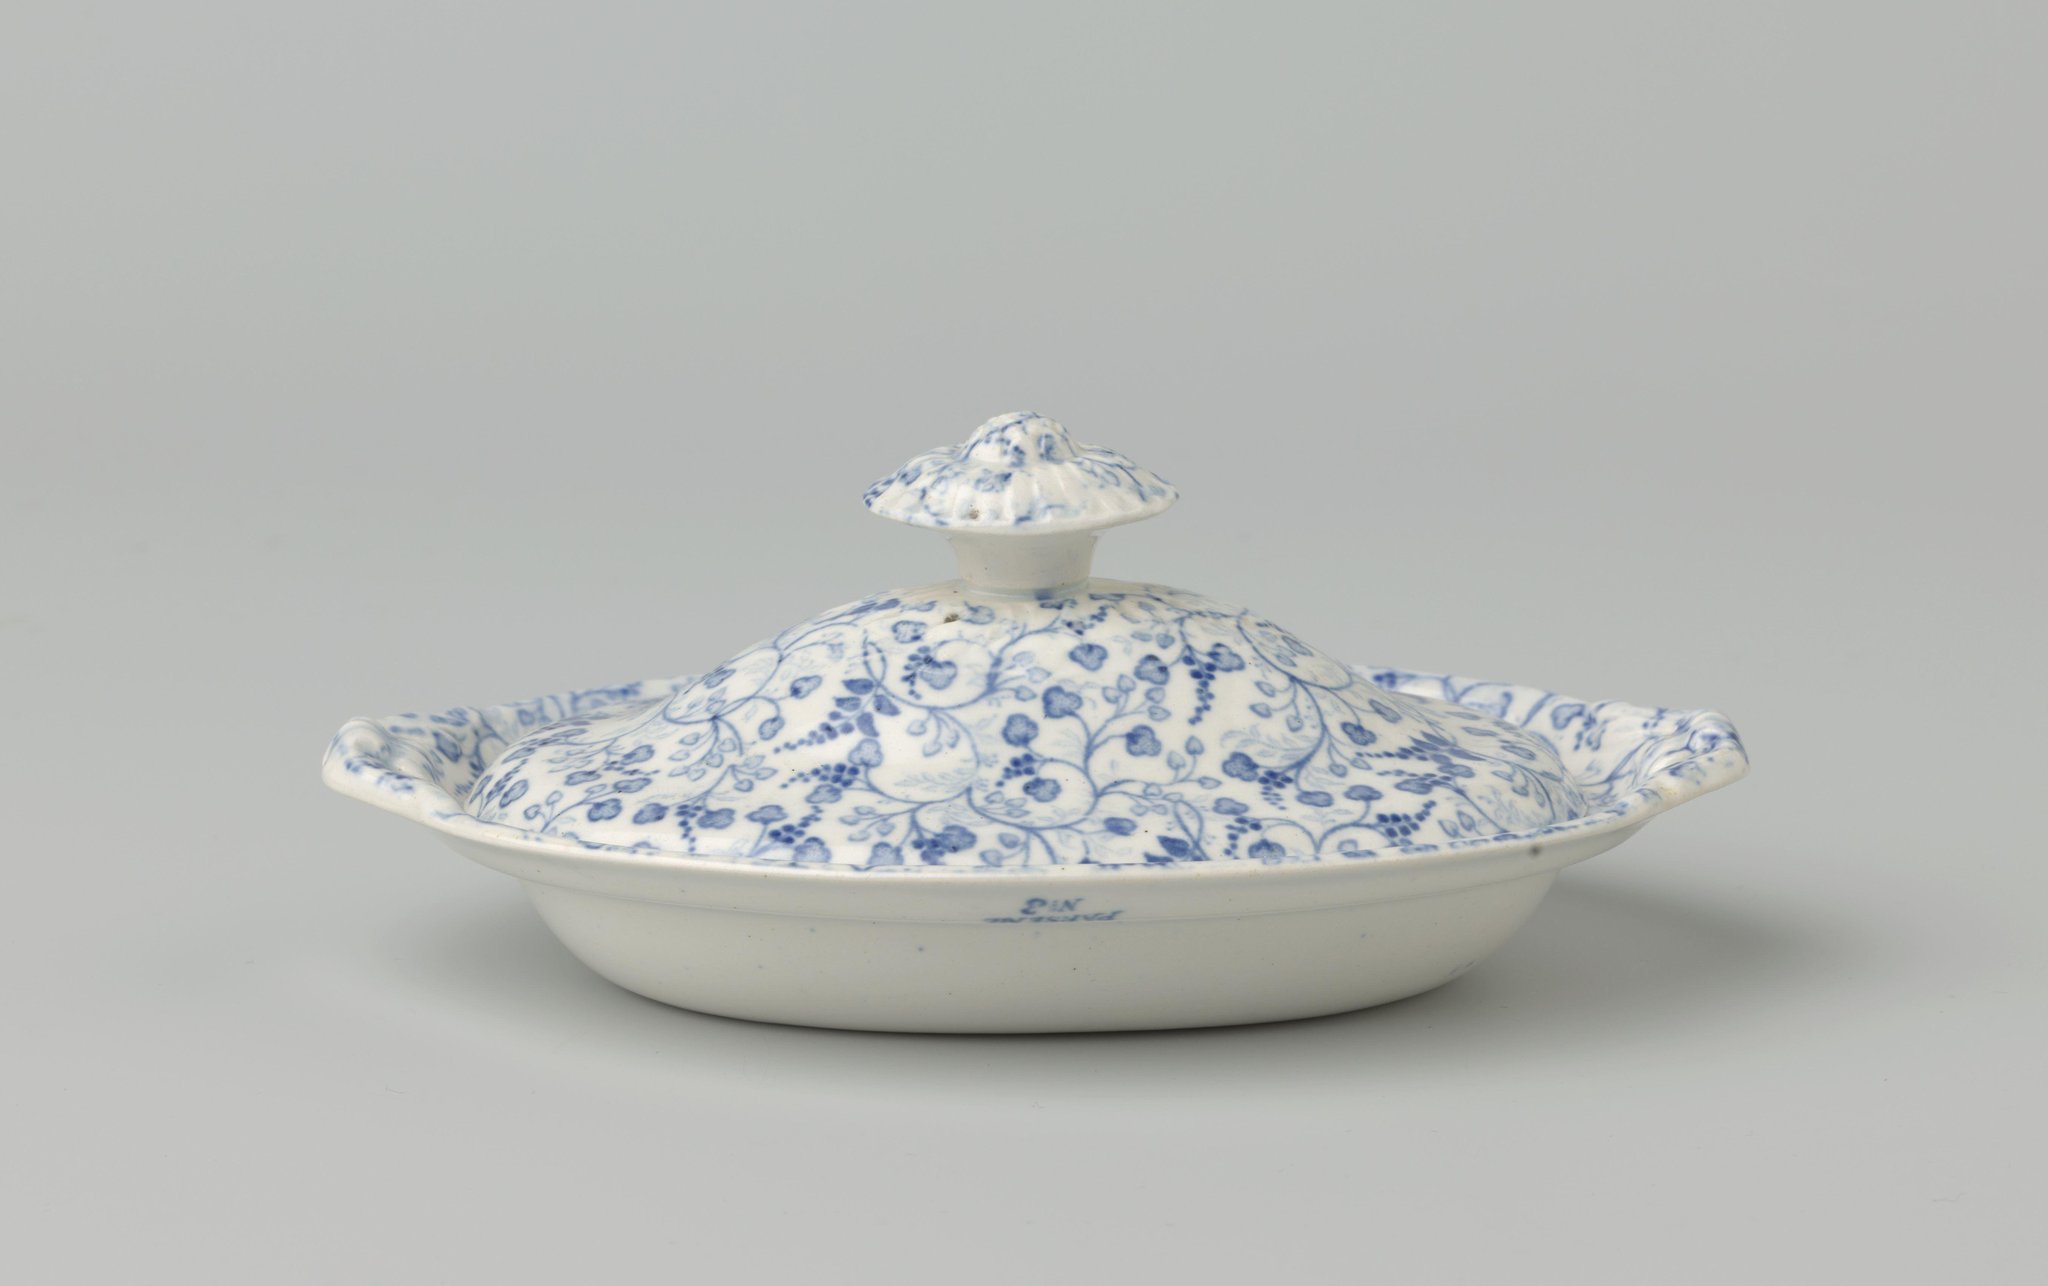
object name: lid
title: Deksel van dekschaal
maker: petrus regout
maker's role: plateelbakker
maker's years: 1801-1879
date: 1867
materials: creamware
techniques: transfer decoration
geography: maastricht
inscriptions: mark: ‘PARSEME No 3 en 2 67’, check stamp: ‘43’, check stamp: ‘PR 43’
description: Deksel van dekschaal van aardewerk met blauw doorlopend bloemendecor, behorend tot een kinderservies. Het ovale, gewelfde deksel is aan de bovenzijde voorzien van bladwerk in reliëf en heeft een bloemvormige knop.